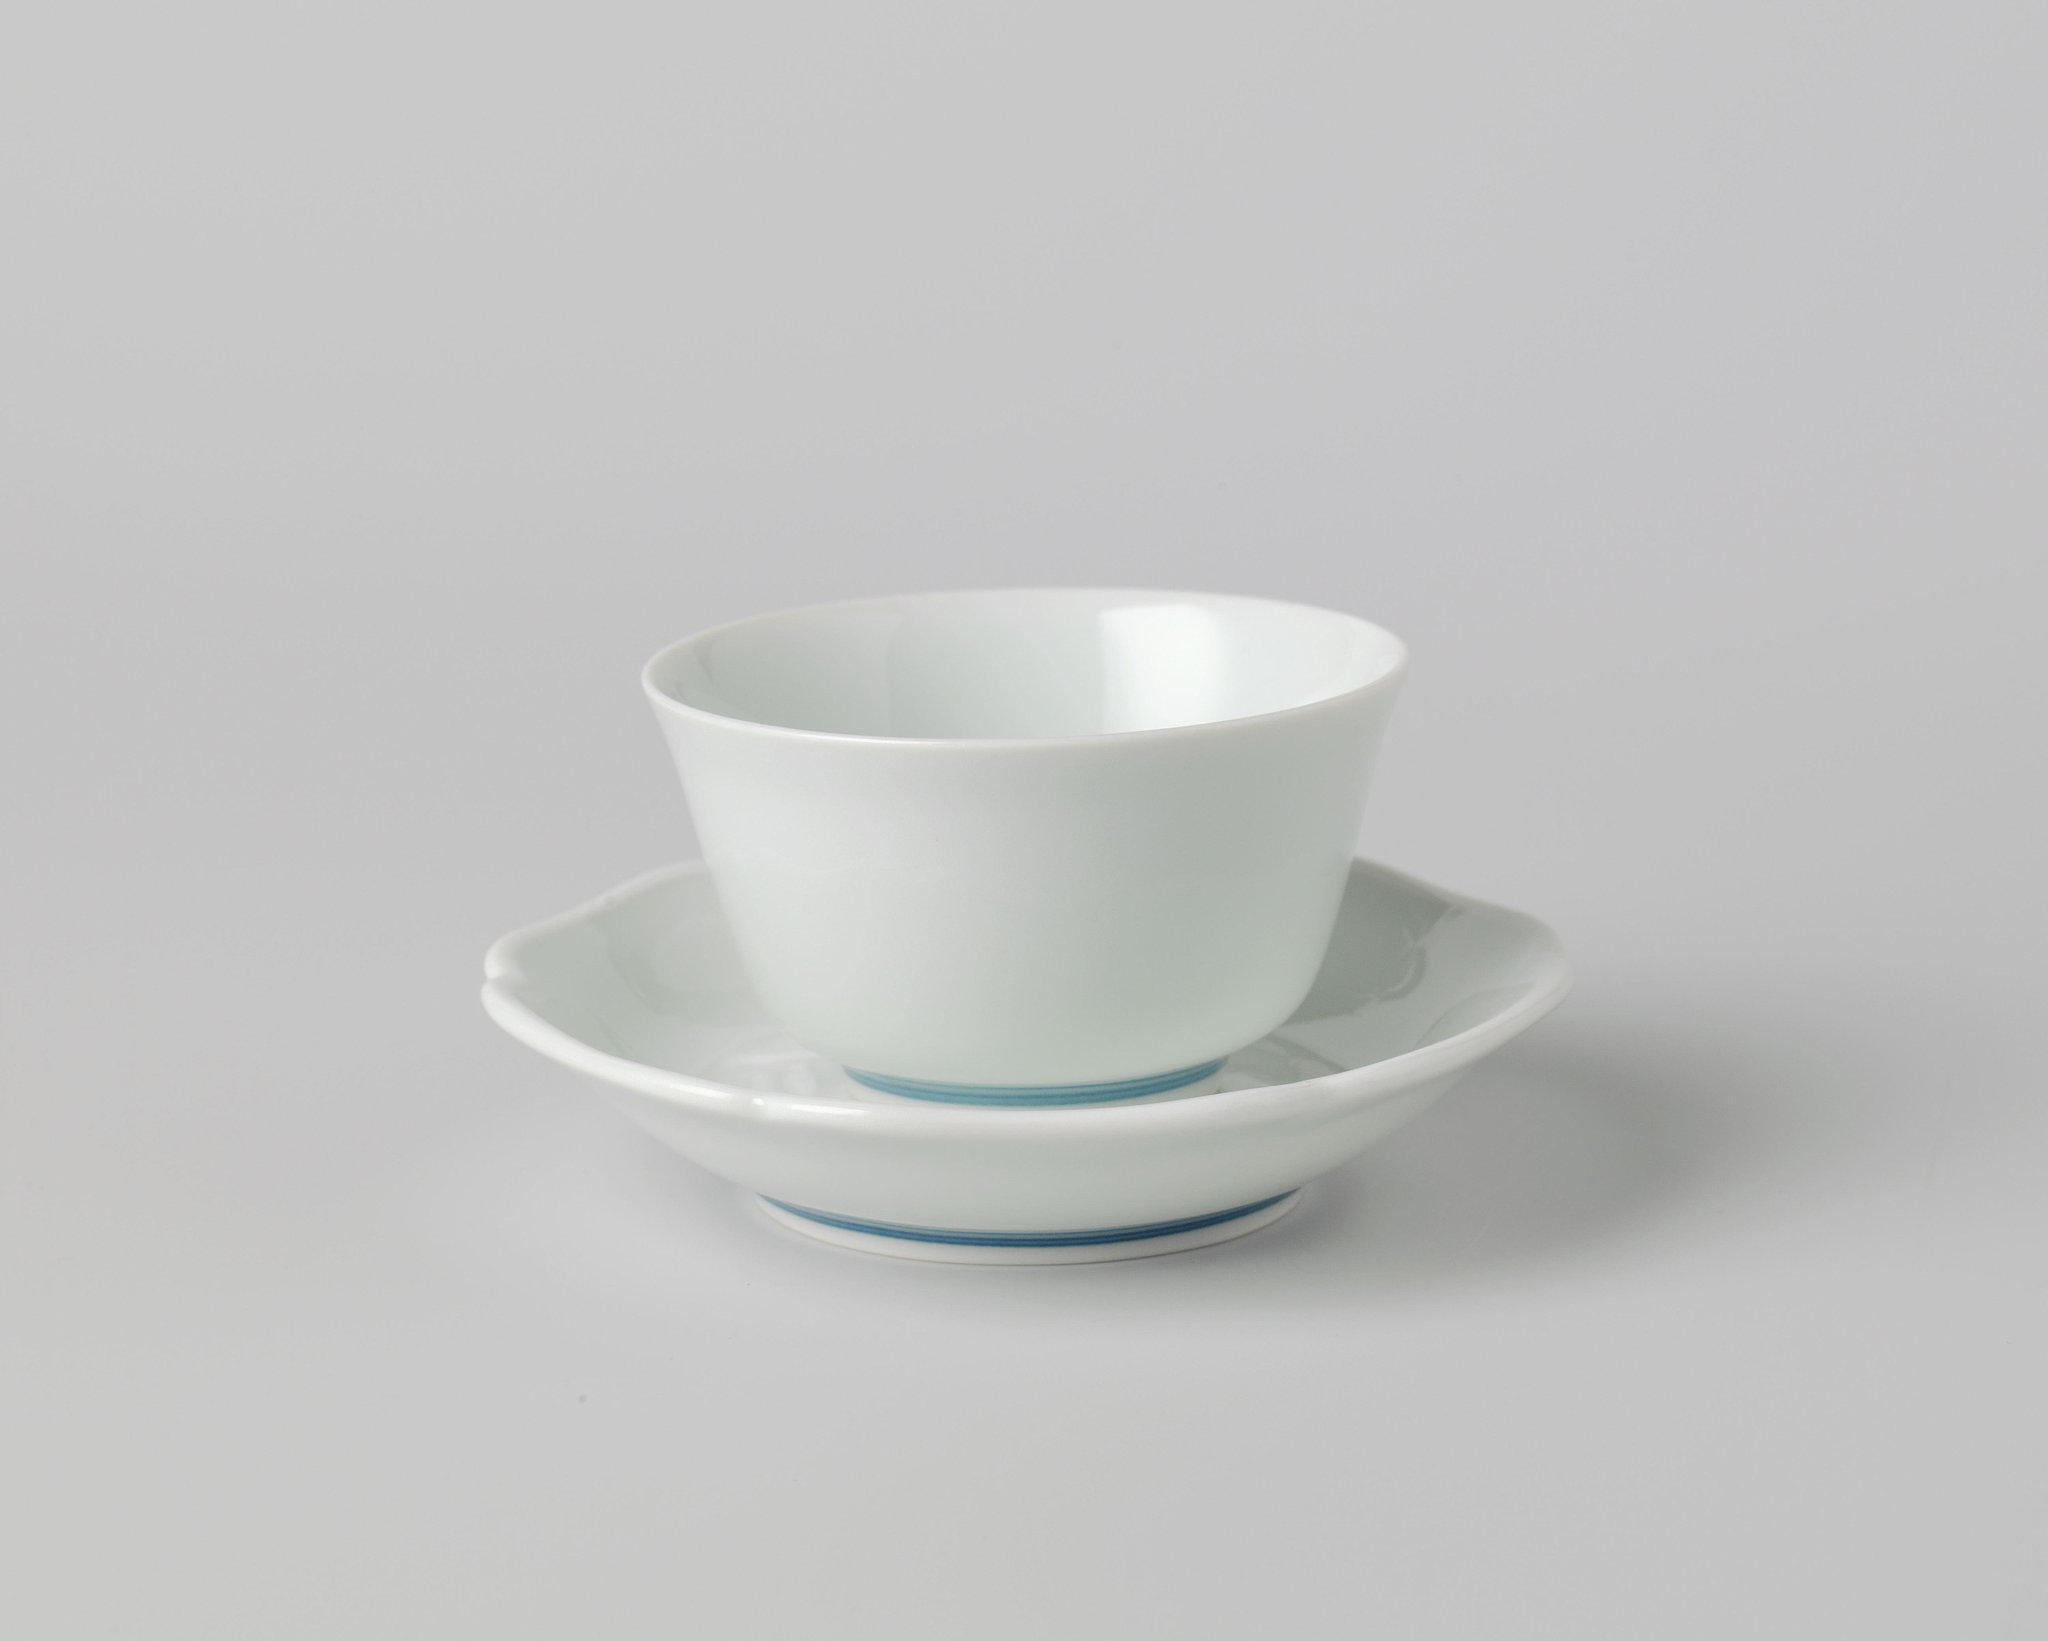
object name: kop en schotel, kop en schotel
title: Two Dishes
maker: masato imaizumi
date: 2002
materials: glaze, porcelain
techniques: firing, relief, turning, vitrification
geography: japan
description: The hare and the moon are a well-known motif on Japanese porcelain. It relates to the legend of a mythical hare living on the moon. The creature pounds rice in a mortar for mochi – sweet rice cakes with the same round shape as the lunar disk.